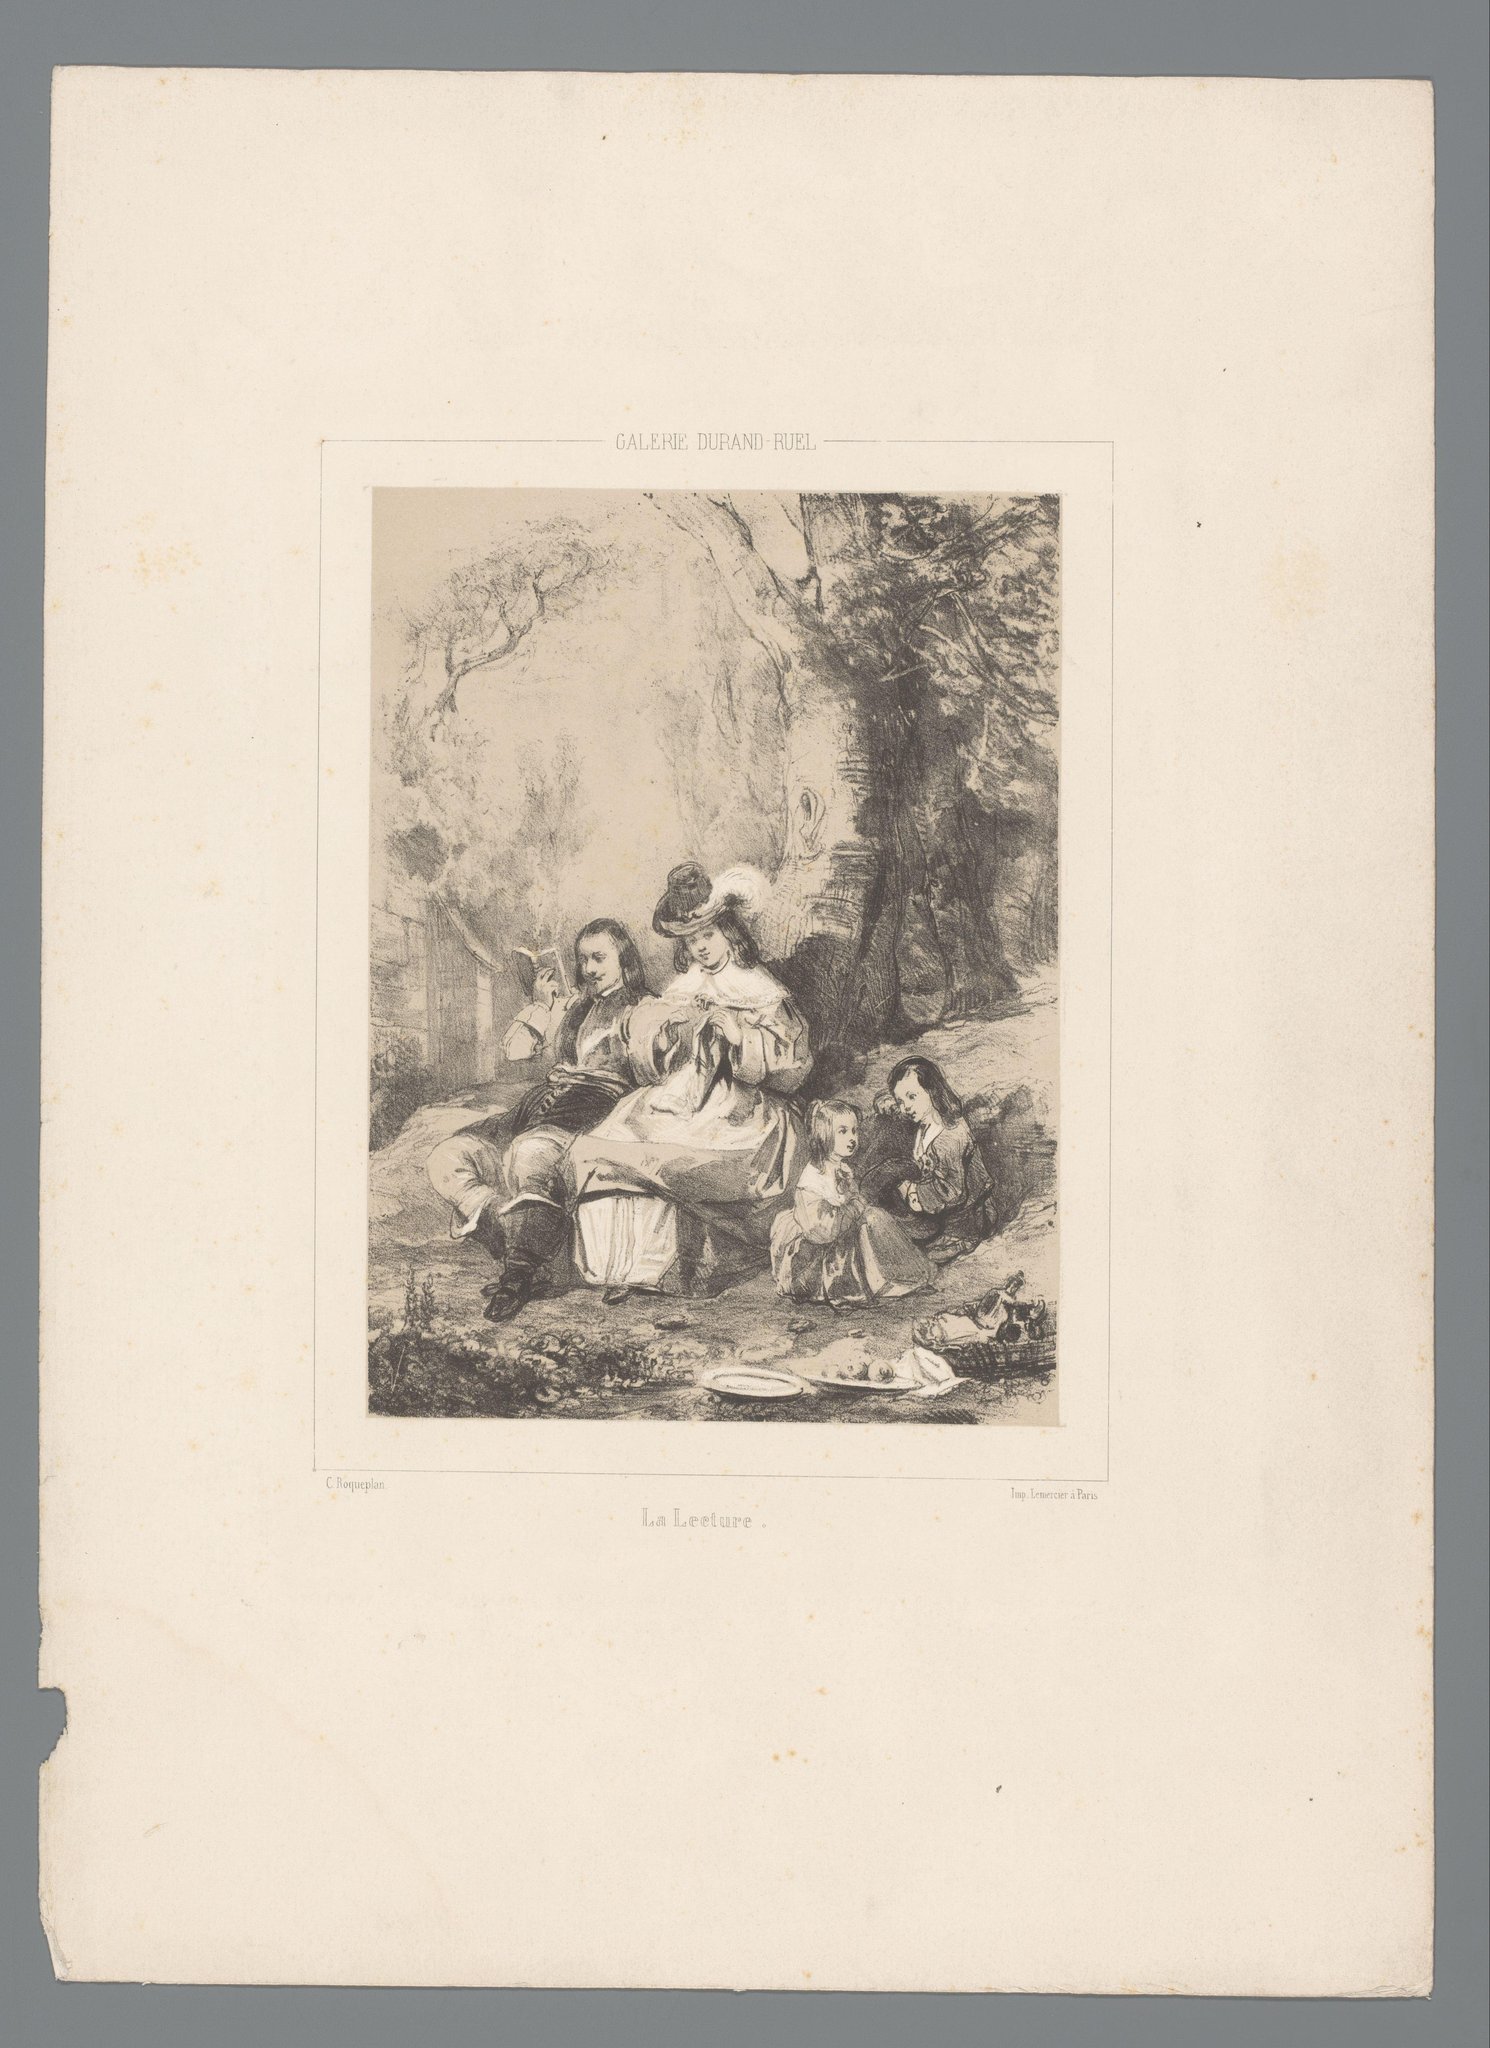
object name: print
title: Vrouw, twee kinderen en lezende man picknicken bij een boom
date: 1843-1845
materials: paper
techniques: tone lithography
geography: paris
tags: book, picnic, alfresco, 'déjeuner sur l'herbe'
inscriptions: collector's mark: Lugt 2228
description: Prent waarschijnlijk uit: Durand, Jean-Marie. Galerie Durand-Ruel. Specimen les plus brillants de l'école moderne. 2 dln. Parijs: Durand-Ruel, 1843-1845.